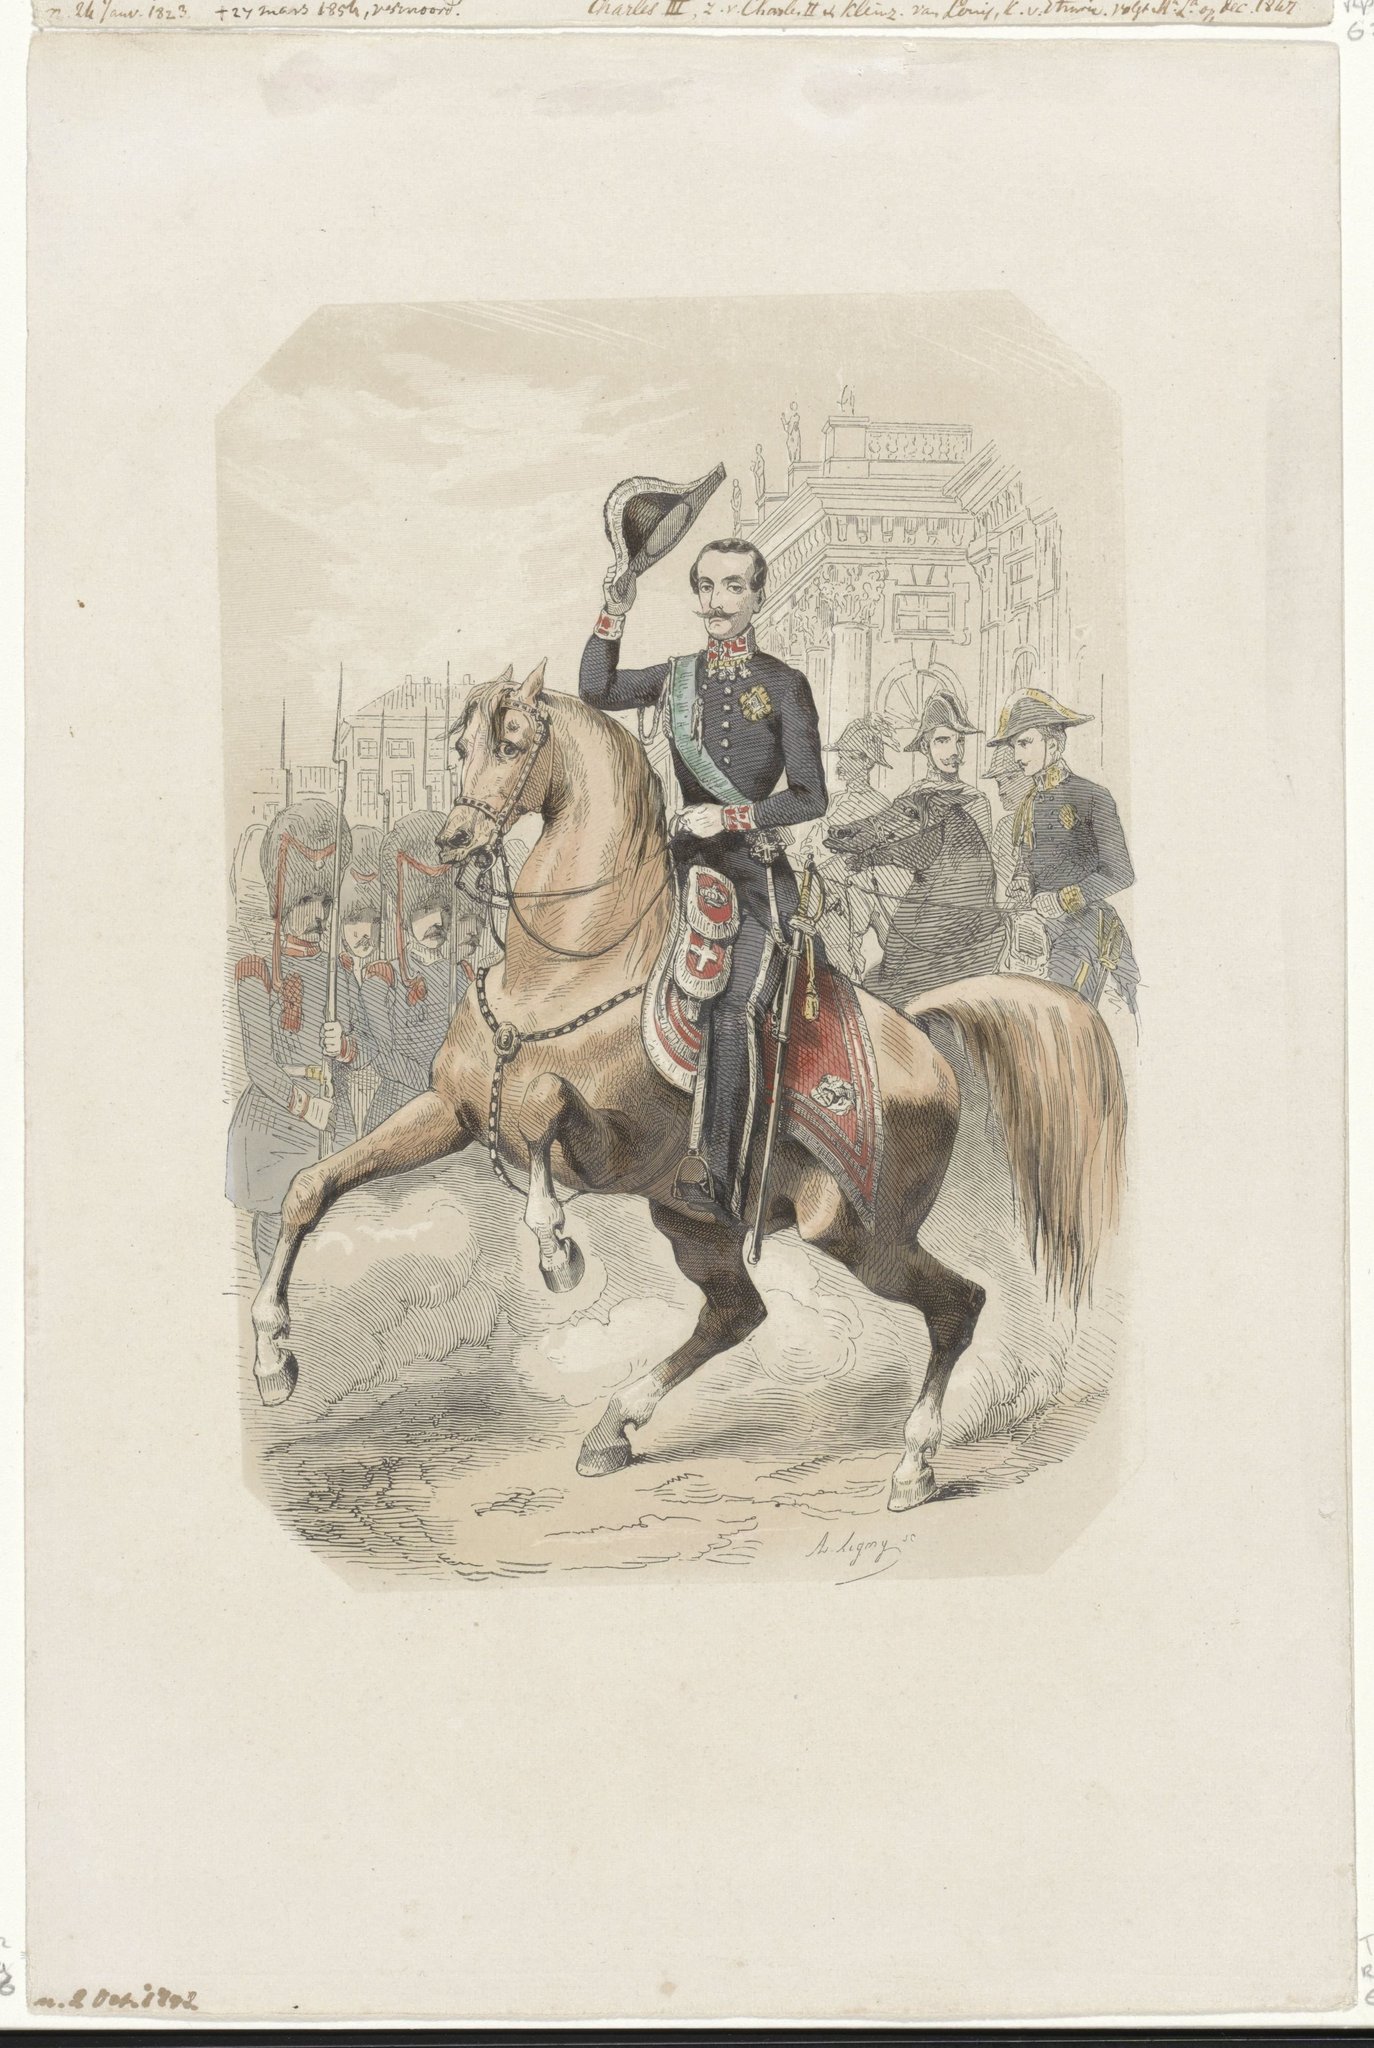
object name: print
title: Portret van Karel Albert, koning van Sardinië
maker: j.l. lacoste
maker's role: print maker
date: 1852-1869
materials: paper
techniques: hand coloring, engraving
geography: netherlands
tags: turijn, porto, koning, karel albert (koning van sardinië)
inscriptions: collector's mark: Lugt 2228